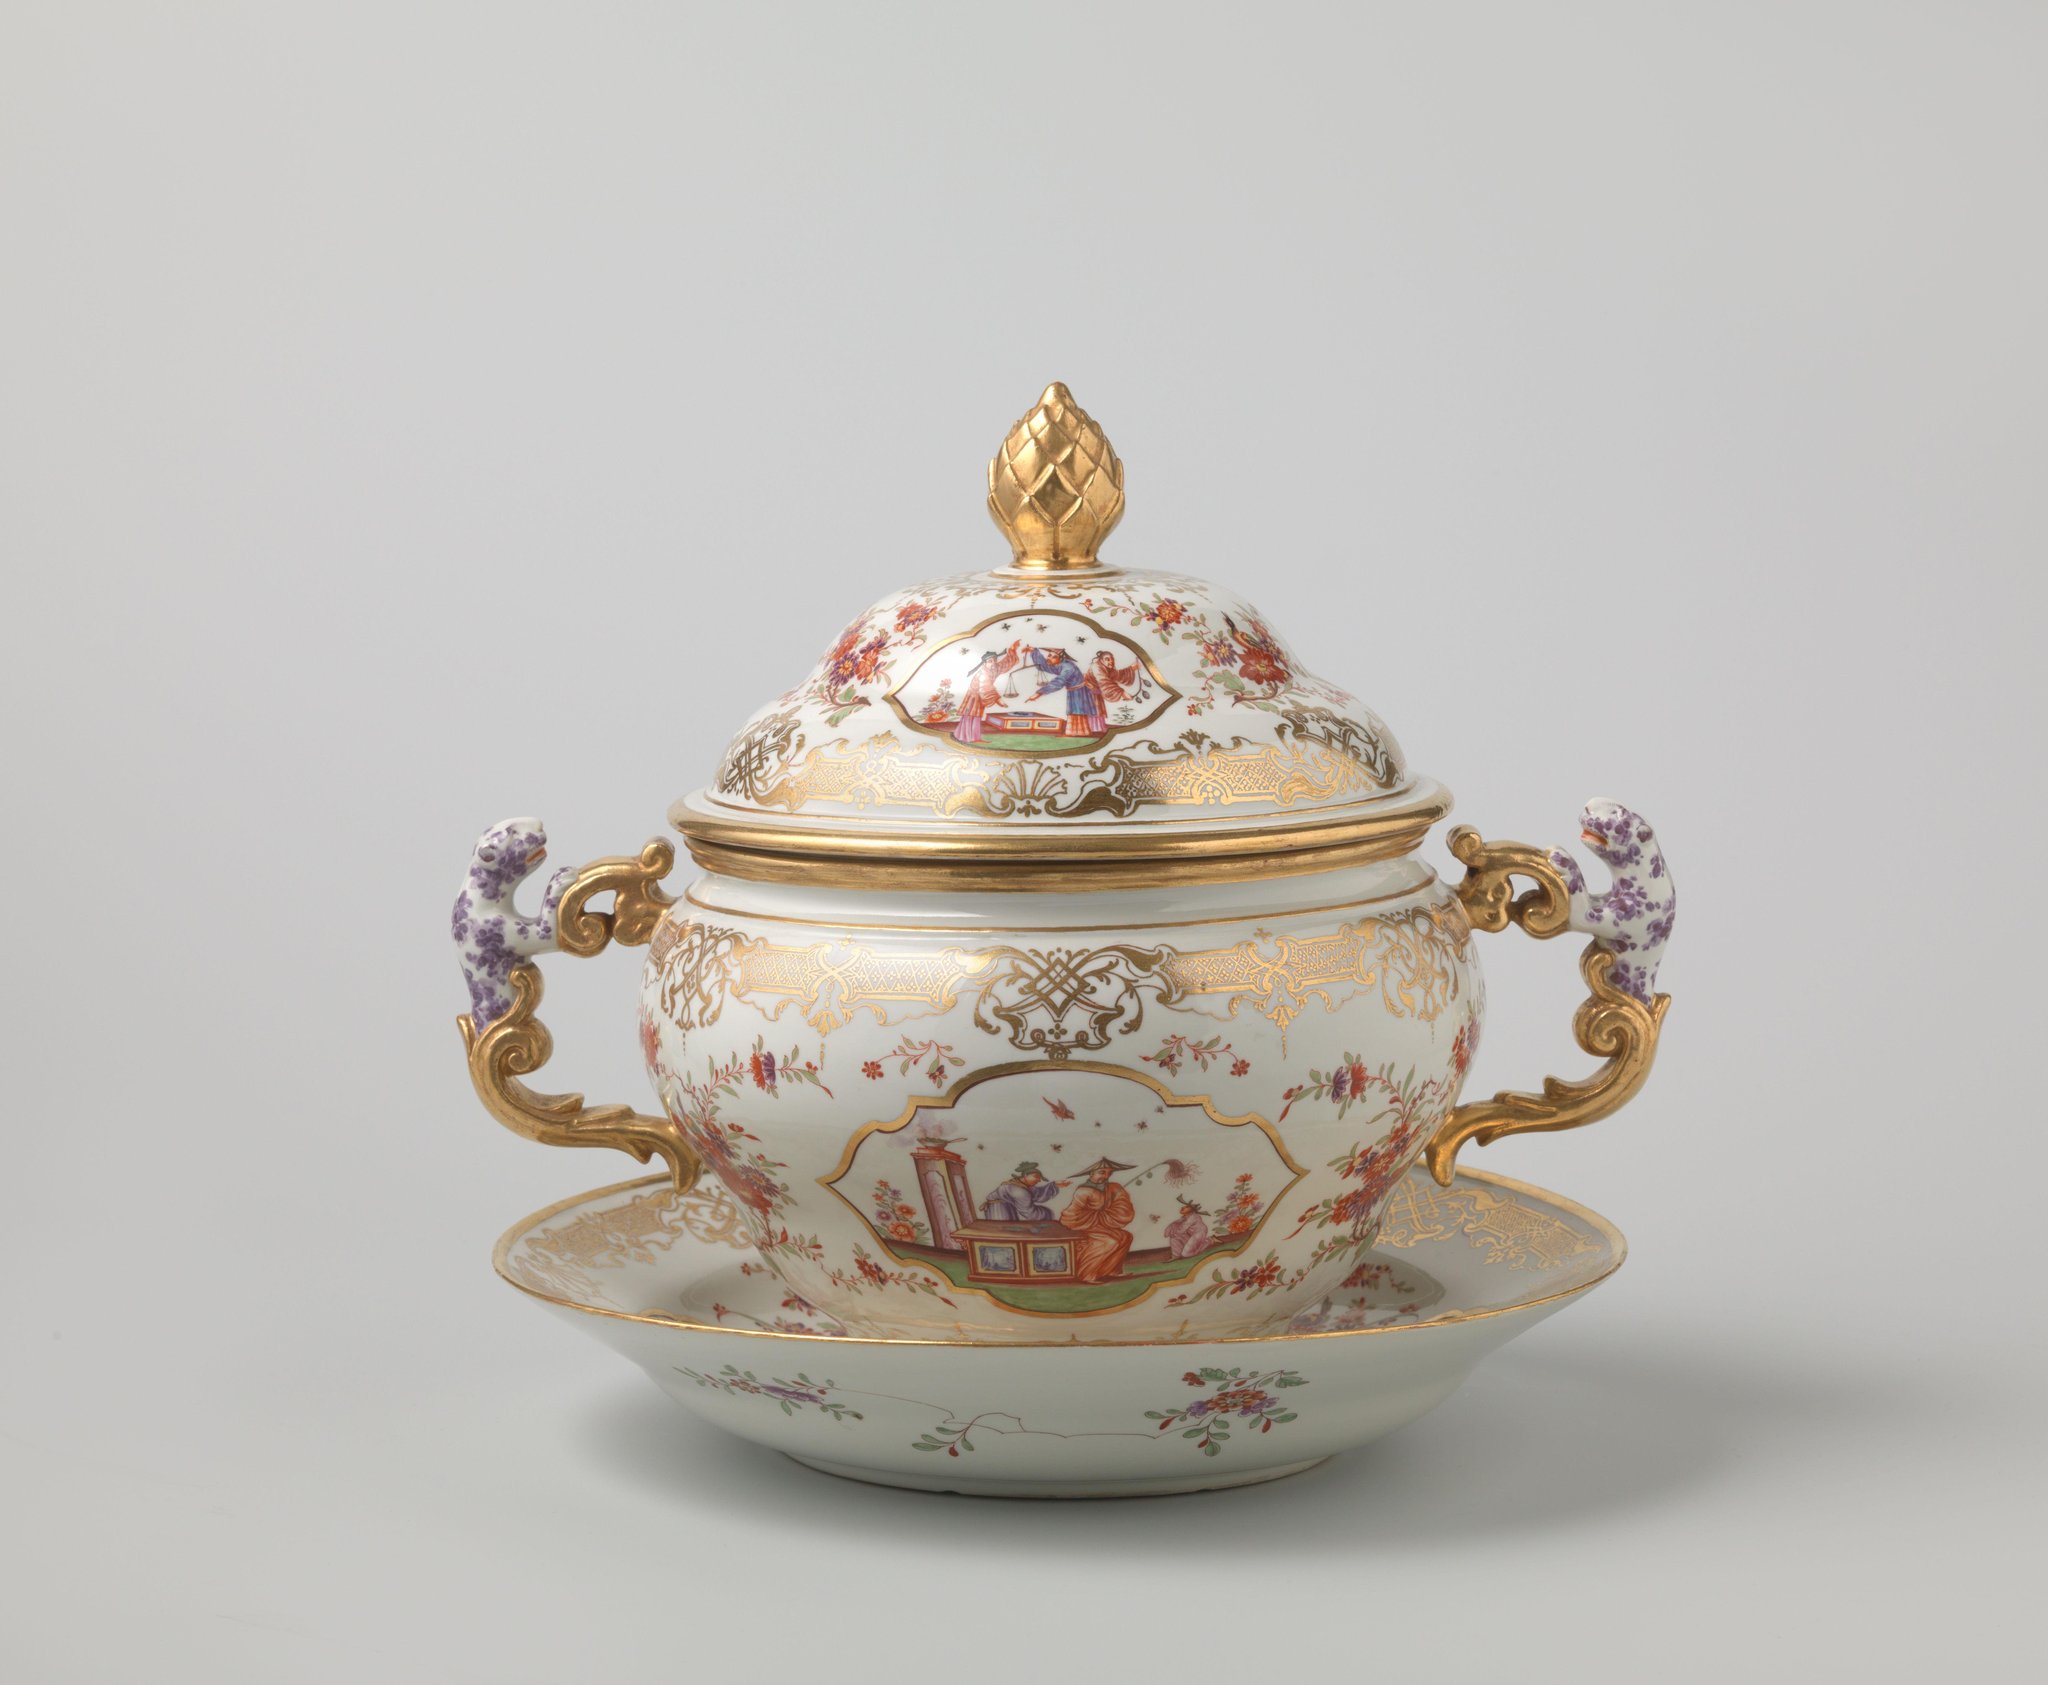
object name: platter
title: Tureen with dish, with Chinese scenes, flower sprays and ornamental borders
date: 1730-1740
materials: glaze, gold, paint, porcelain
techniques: firing, forming, gilding, turning, vitrification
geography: vienna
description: Tureen and stand. Porcelain, Vienna, factory of Claude Innocent Du Paquier, c. 1730 - 1735.